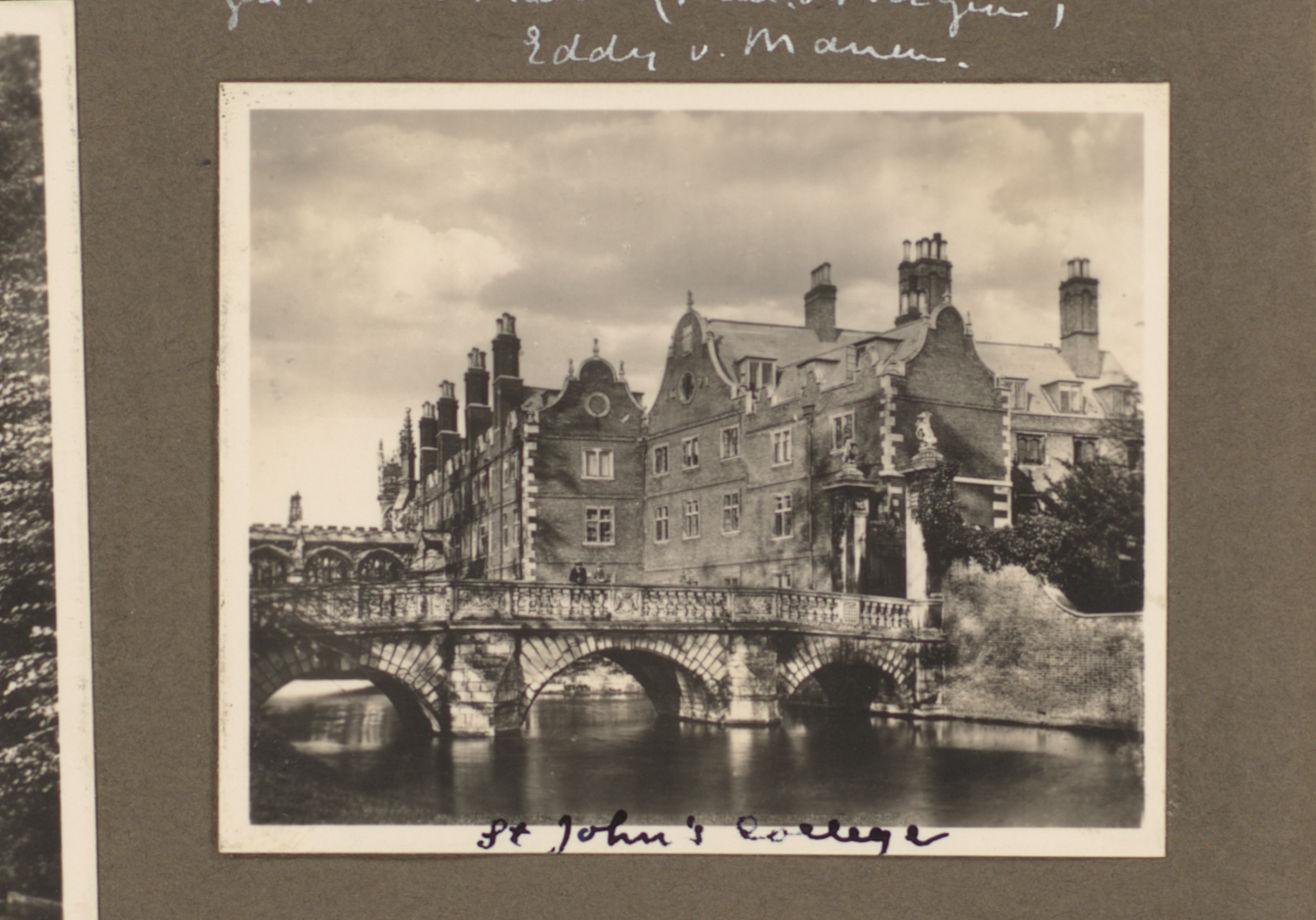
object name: photograph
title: St. John's College, Cambridge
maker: Anonymous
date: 1932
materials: paper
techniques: gelatin silver print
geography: cambridge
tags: university building, college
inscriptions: inscription: ‘St John's College’